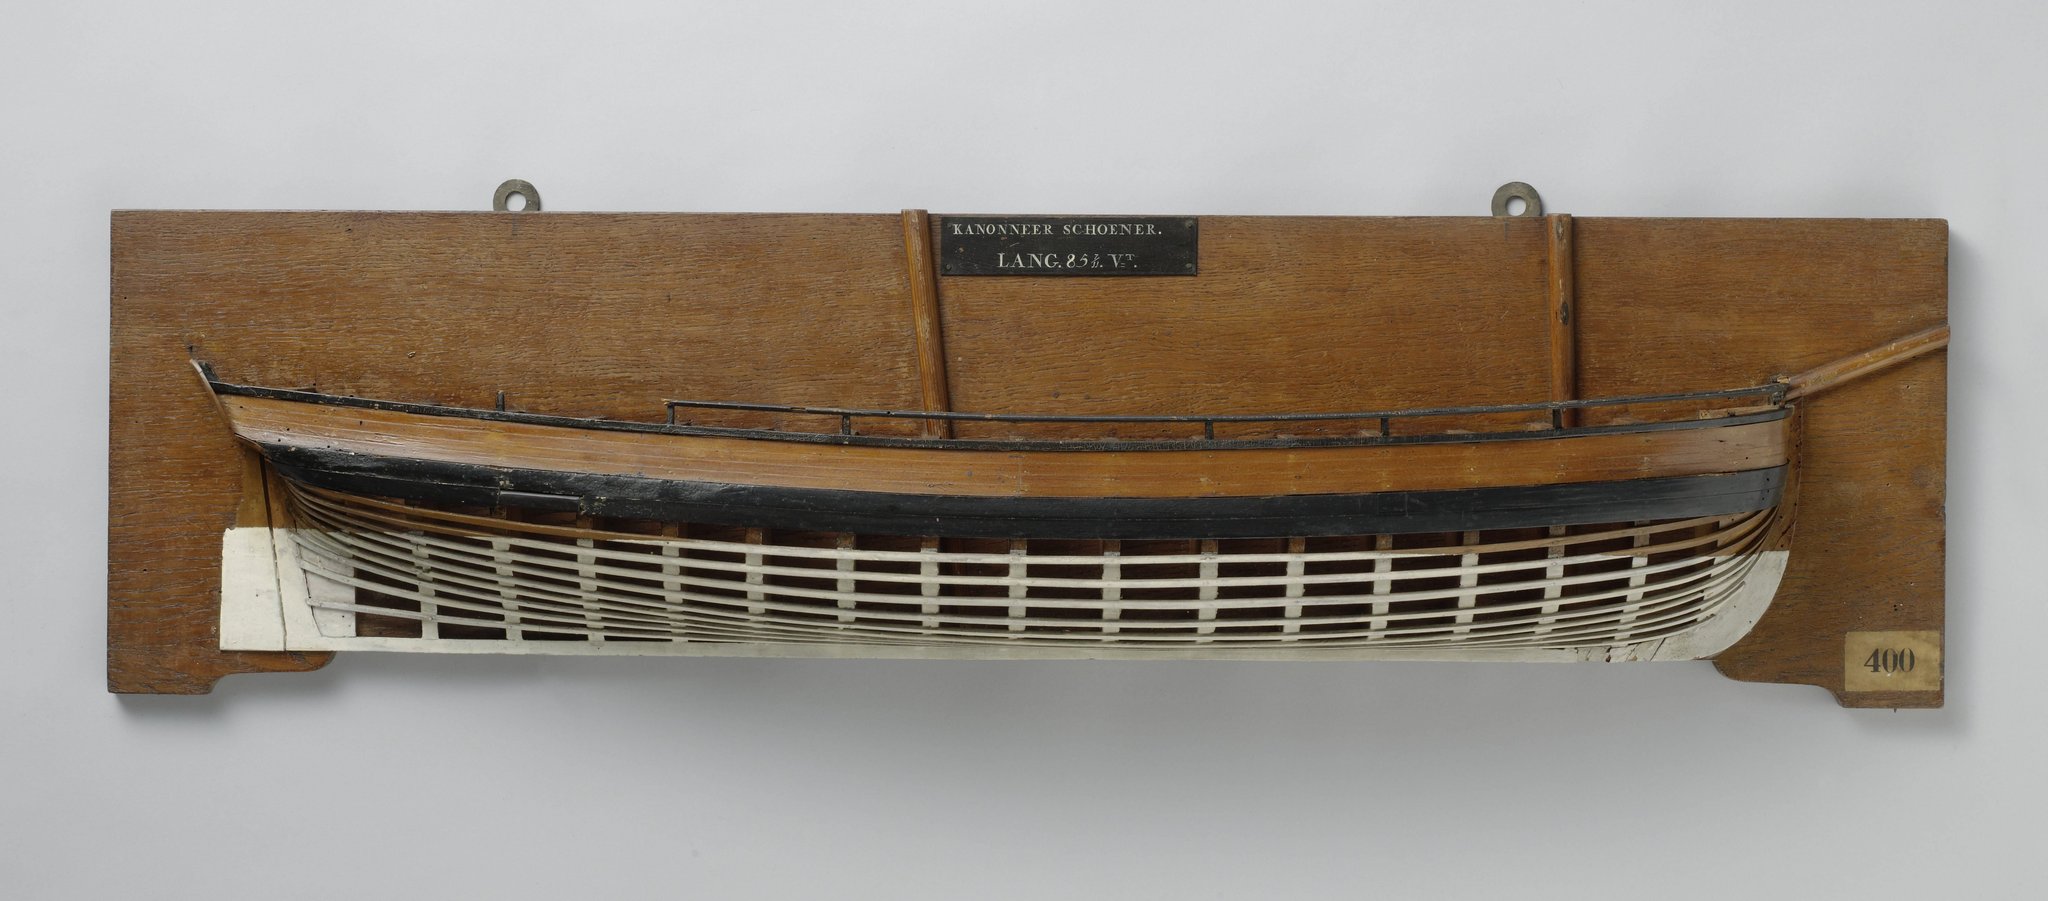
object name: ship model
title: Half Model of a Schooner Gunboat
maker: Anonymous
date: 1780-1820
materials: wood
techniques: polychromy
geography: netherlands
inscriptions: inscription, top centre, on a rectangular black label: ‘KANONNEER SCHOENER. / LANG. 85 7/11 Vt.’, label, bottom right: ‘400’ former inventory label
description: Gepolychromeerd mallenmodel (stuurboord) van een tweemaster. De huid boven het barkhout is gesloten, het schip heeft een reling. Gewrongen spiegel, hol wulf, geen details van het hek, geen zijgalerij; recht roer met vierkante roerkoning. Zeeg naar beide einden oplopend, één barkhout en één reehout. Gepiekt rondspant. Schaal ca. 1:30 (afgeleid).